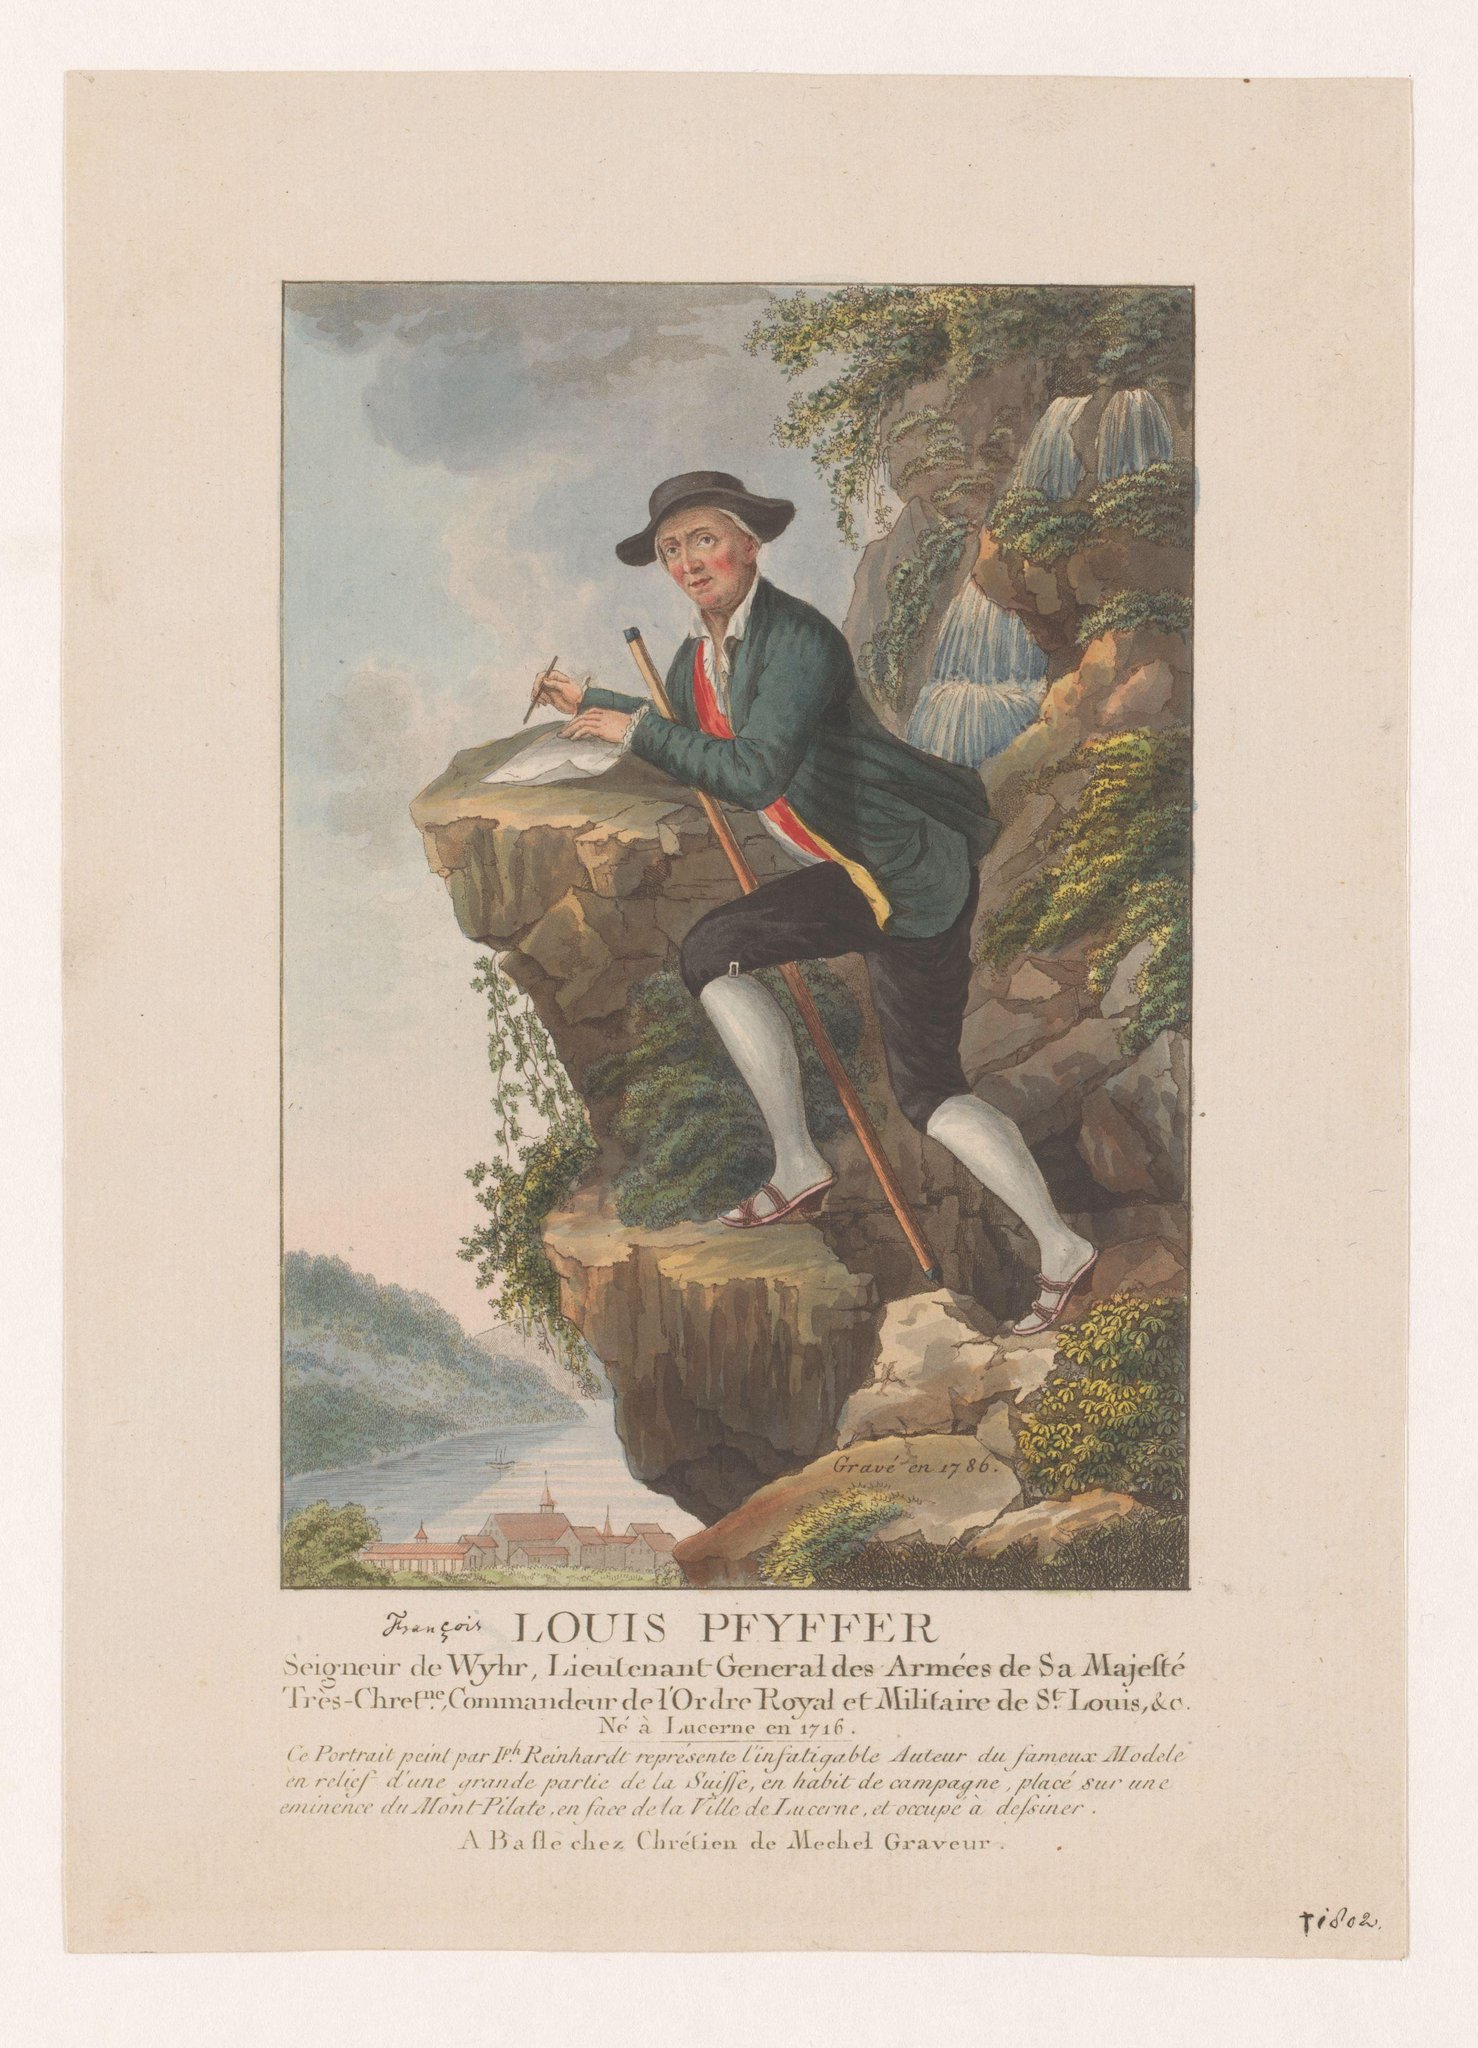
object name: print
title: Portret van Franz Ludwig Pfyffer in de bergen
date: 1786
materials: paper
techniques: etching, hand coloring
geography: basel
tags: mountain climbing, mountaineering, science and technology (+ portrait of scholar, scientist)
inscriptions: collector's mark: Lugt 2228